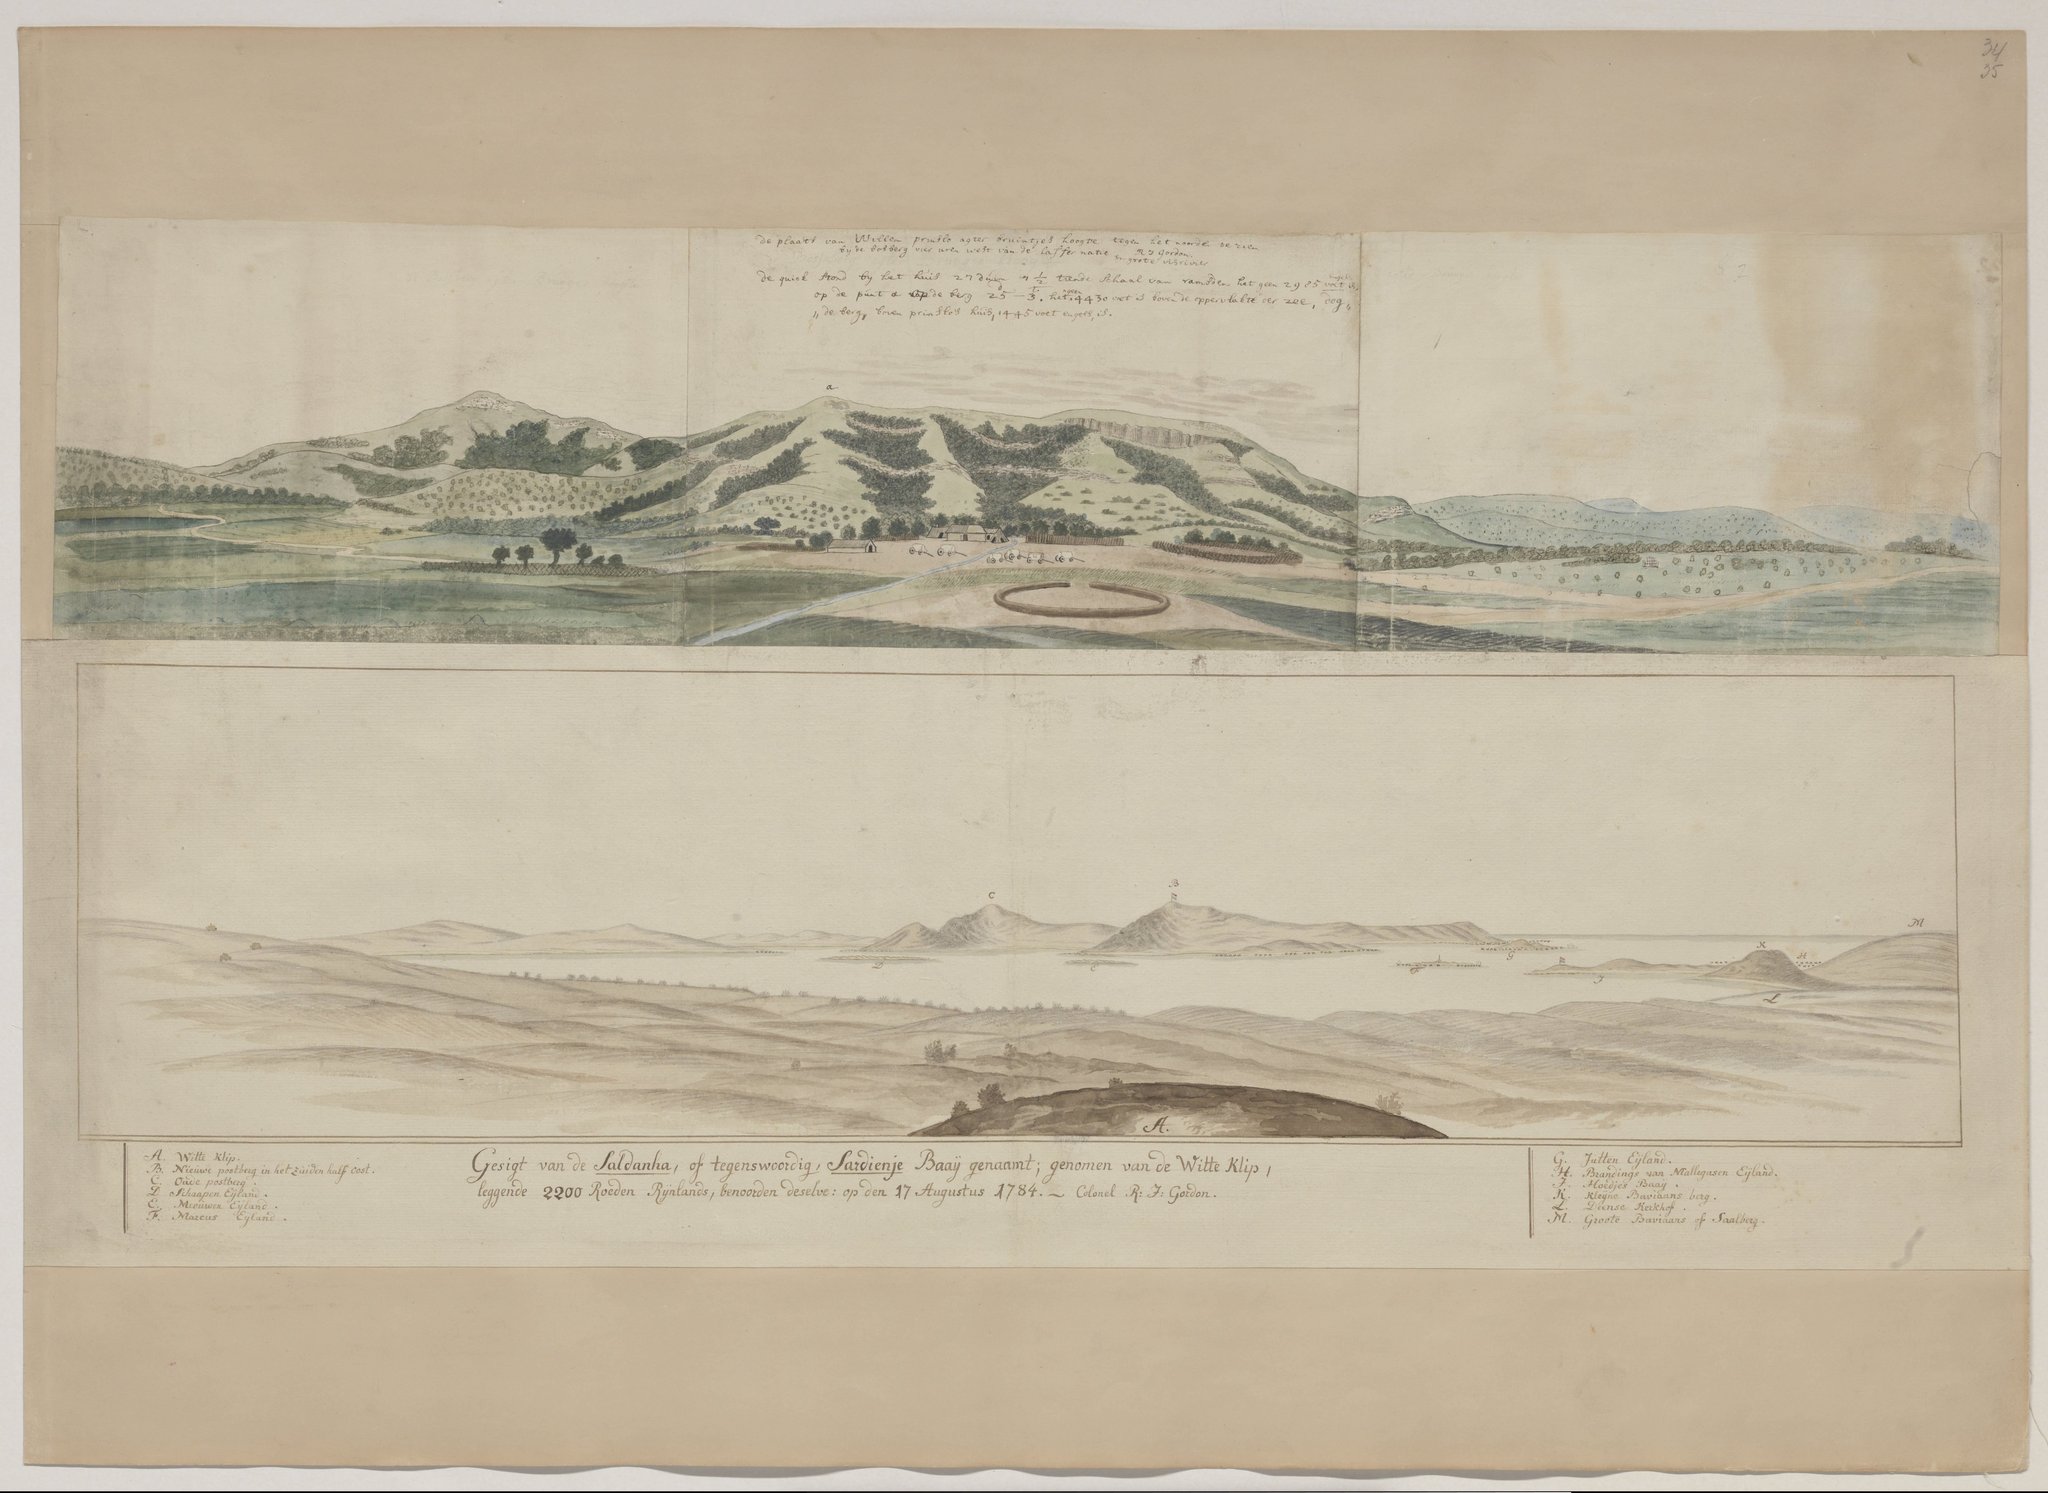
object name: topographical view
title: Stock-farm of Willem Prinsloo, near Bruintjes Hoogte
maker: robert jacob gordon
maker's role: draughtsman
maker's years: 1743-1795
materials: ink, paper, pencil, watercolor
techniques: brush, pen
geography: cape province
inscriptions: annotation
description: Oorspronkelijk in omslag van roodkleurig halfleer en roodgemarmerd plat, dorso met ribben en goudopdruk; 71 x 99 x 6 cm.